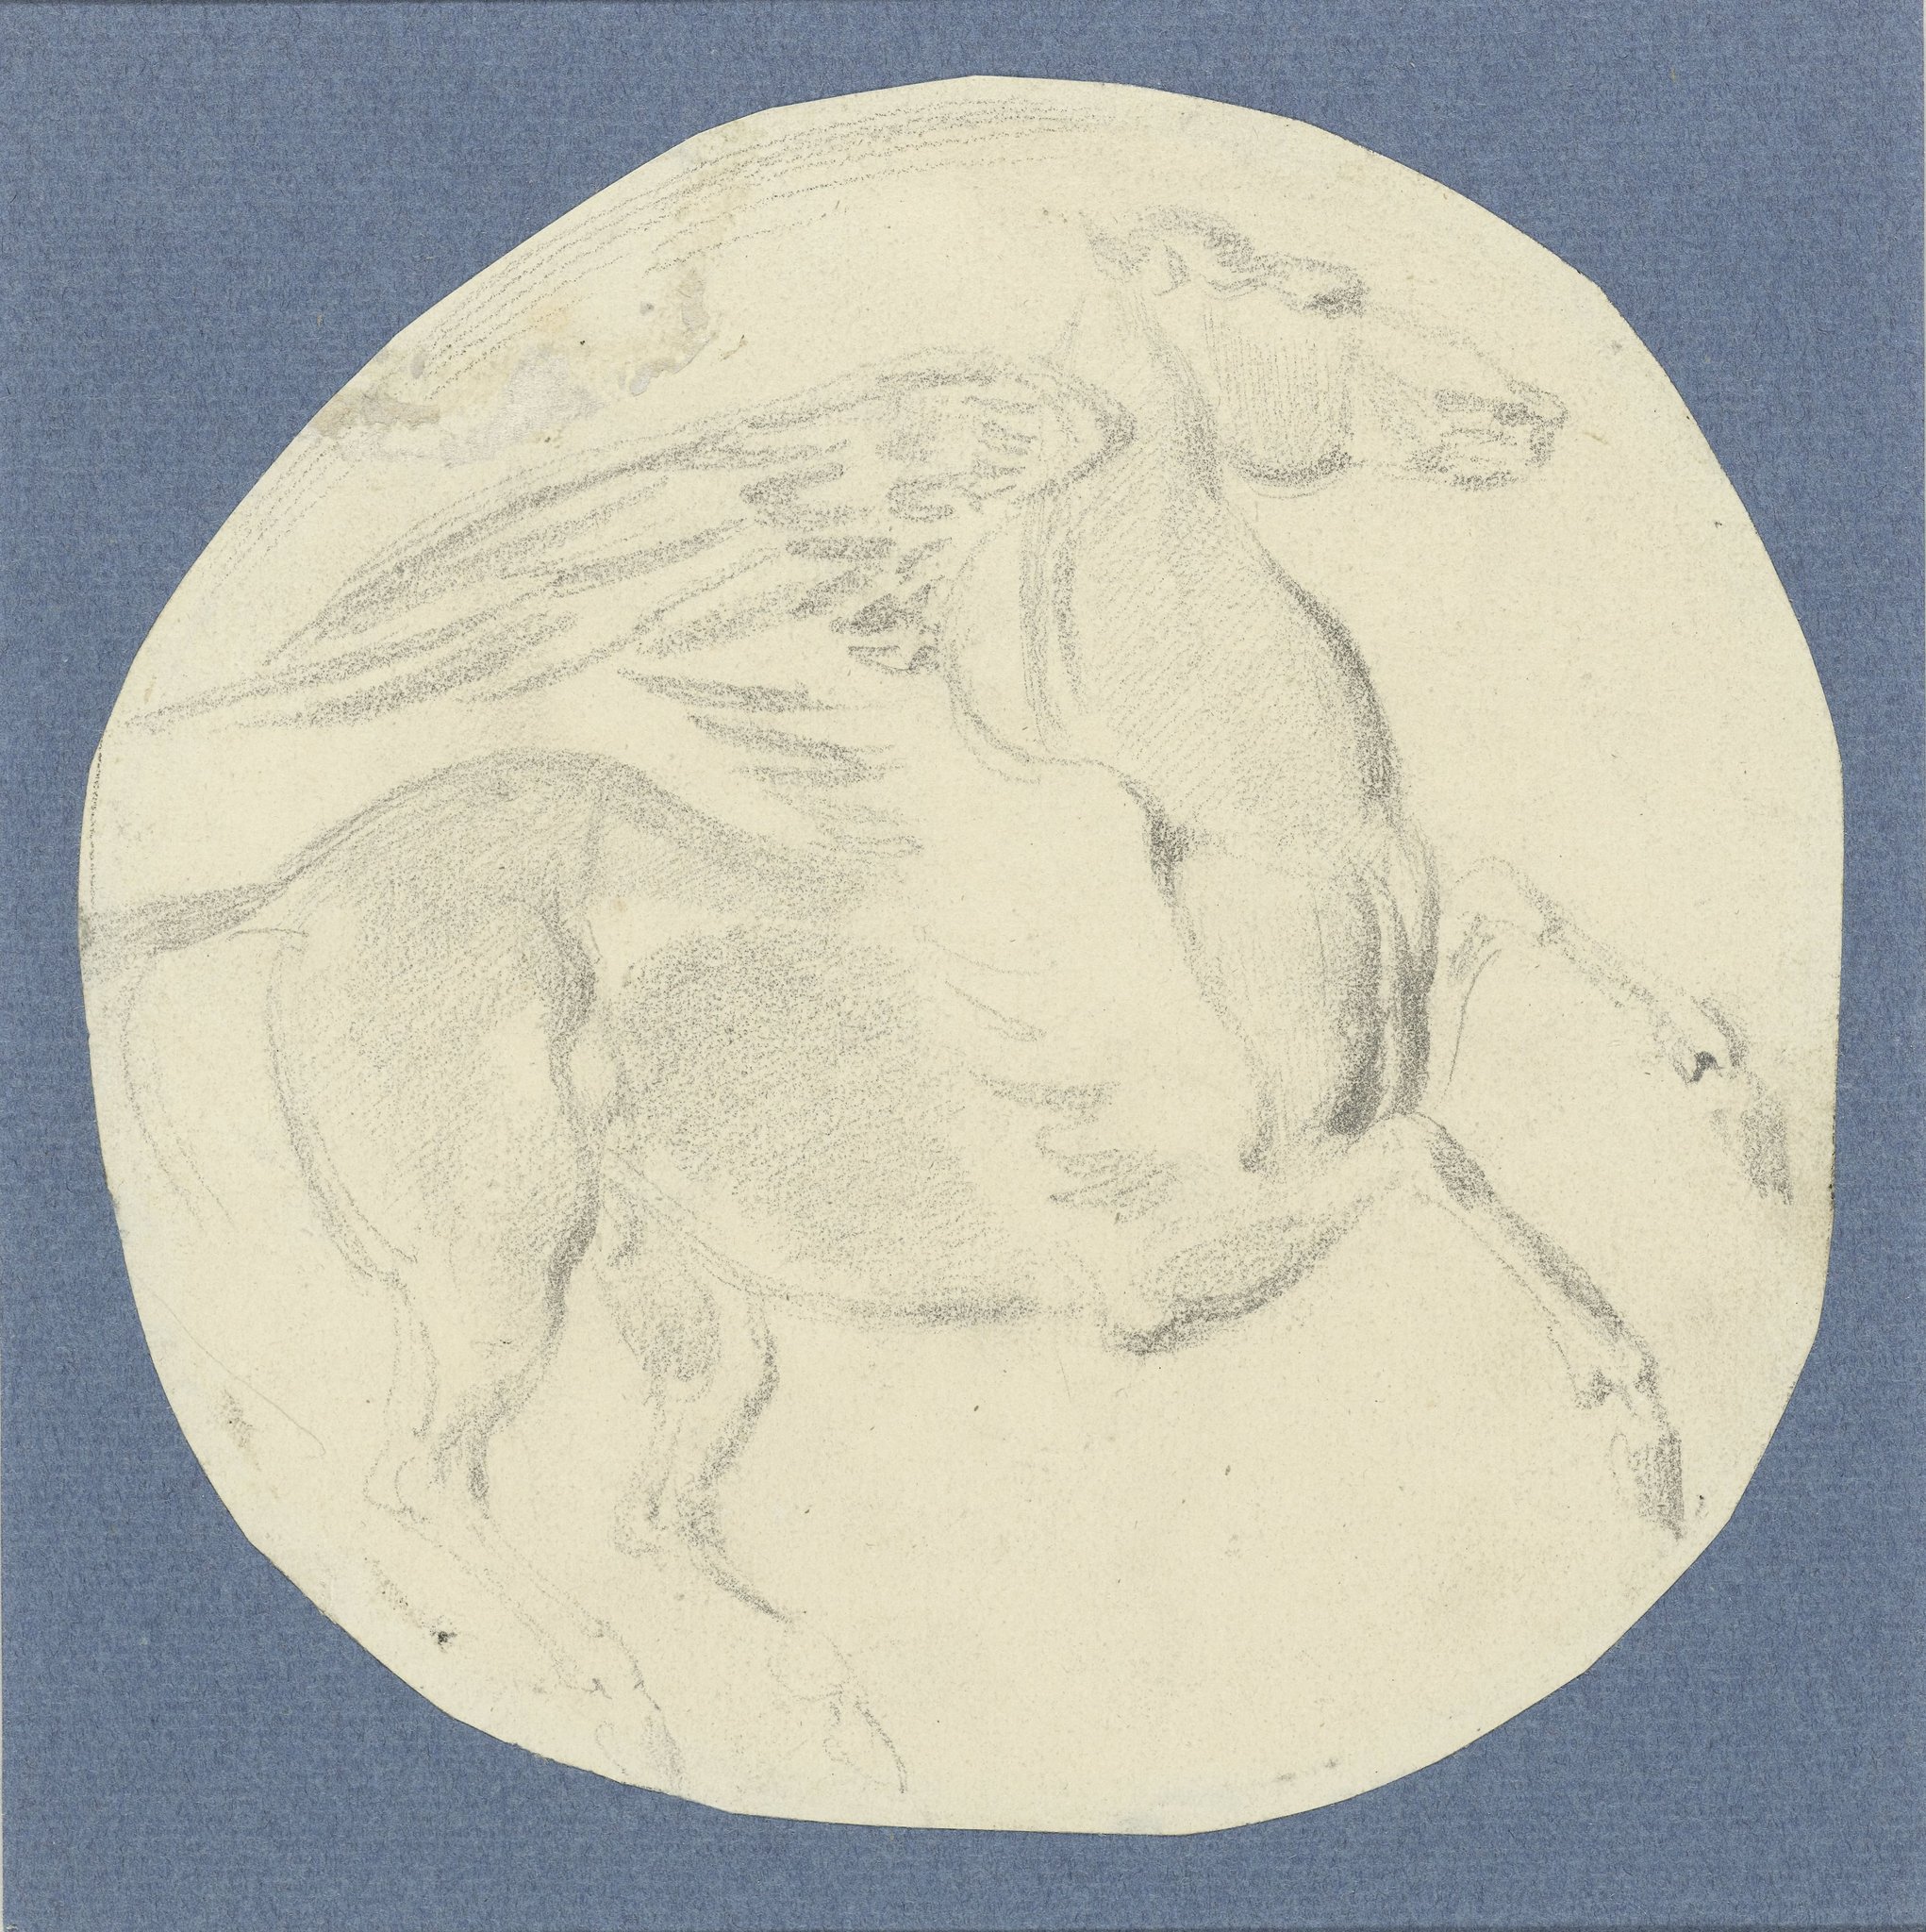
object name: drawing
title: Pegasus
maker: louis boulanger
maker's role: draughtsman, print maker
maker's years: 1806-1867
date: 1816-1867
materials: paper, pencil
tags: pegasus, the winged horse